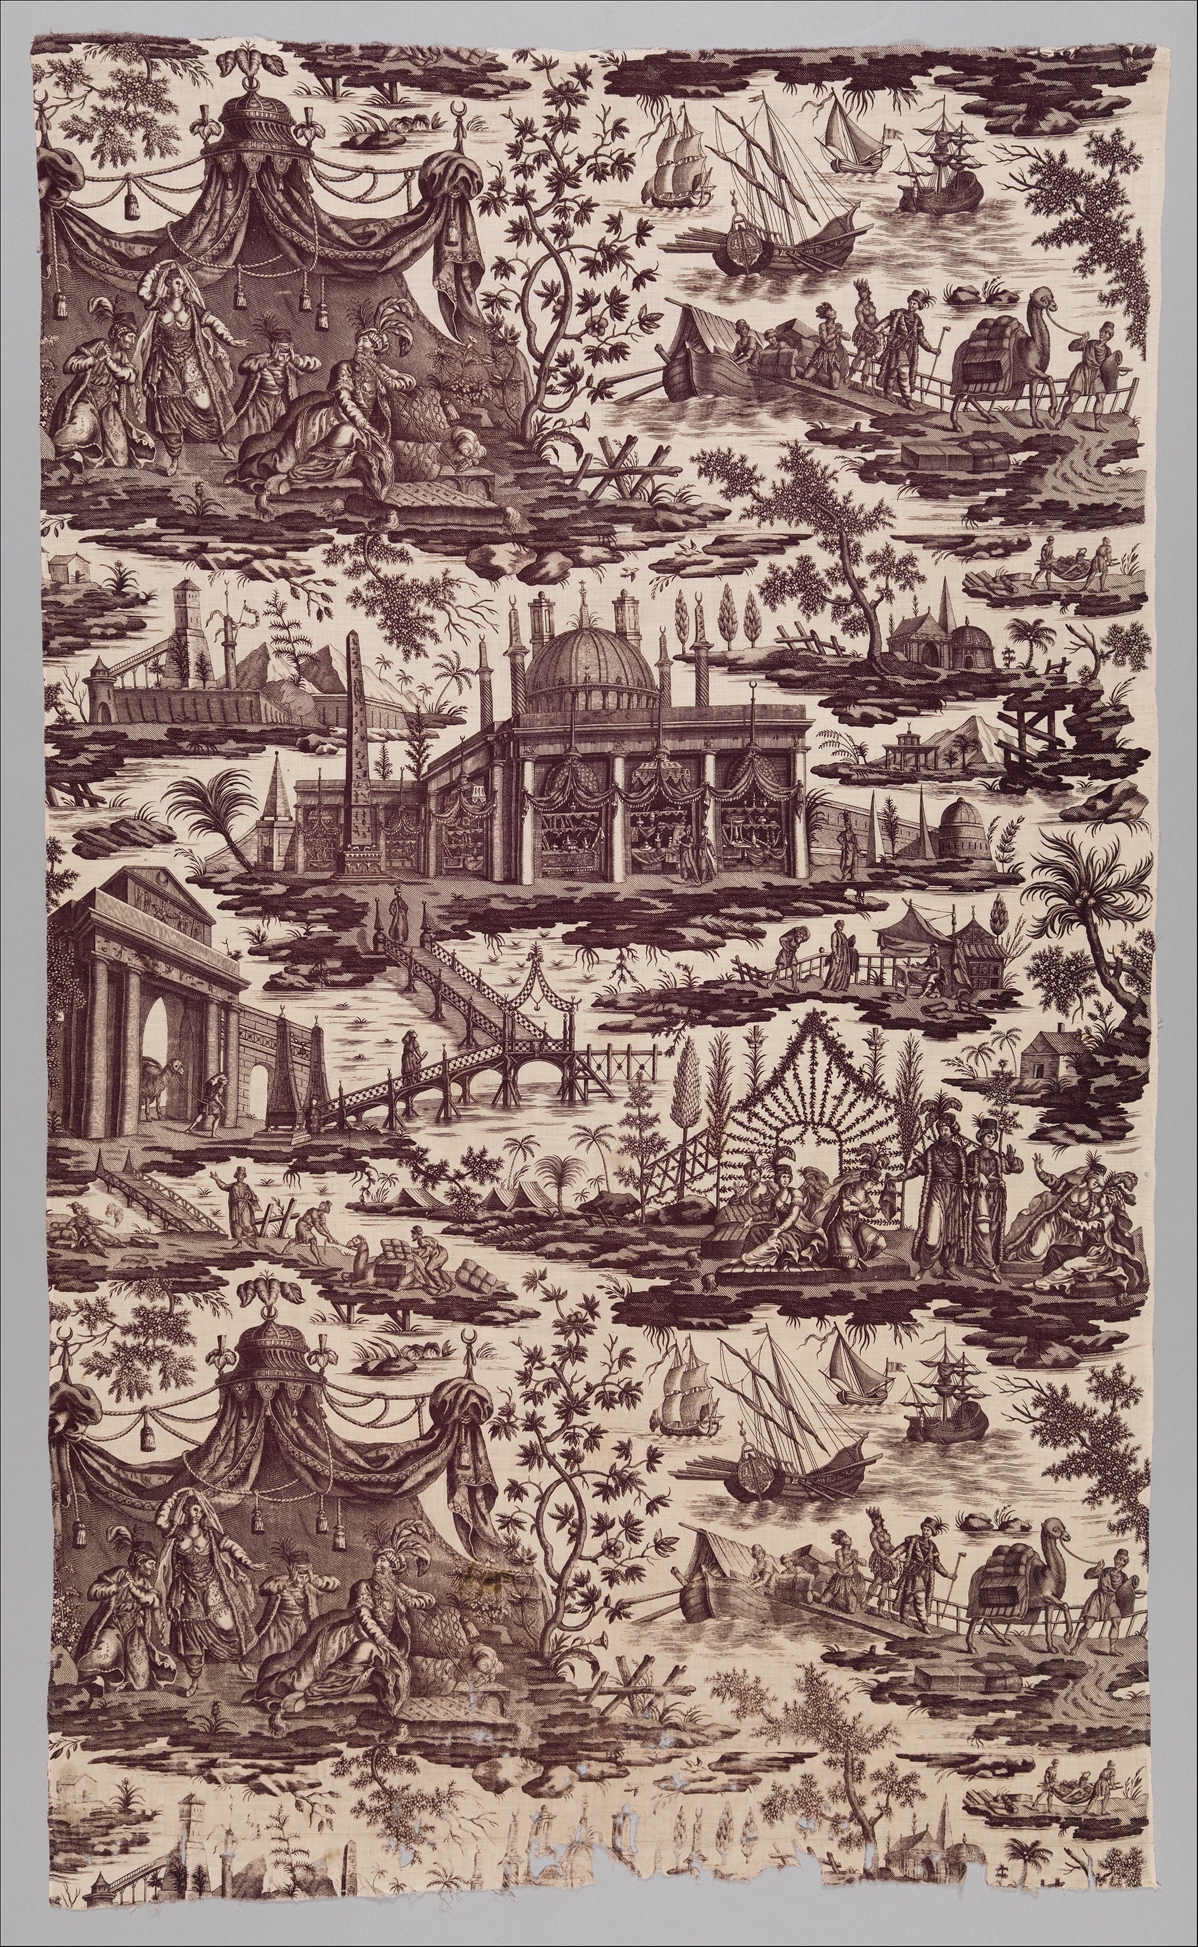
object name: piece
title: La Caravane du Caire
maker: favre petitpierre et cie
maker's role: artist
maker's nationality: french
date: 1801-1833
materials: cotton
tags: tombs,men,women,trees,boats